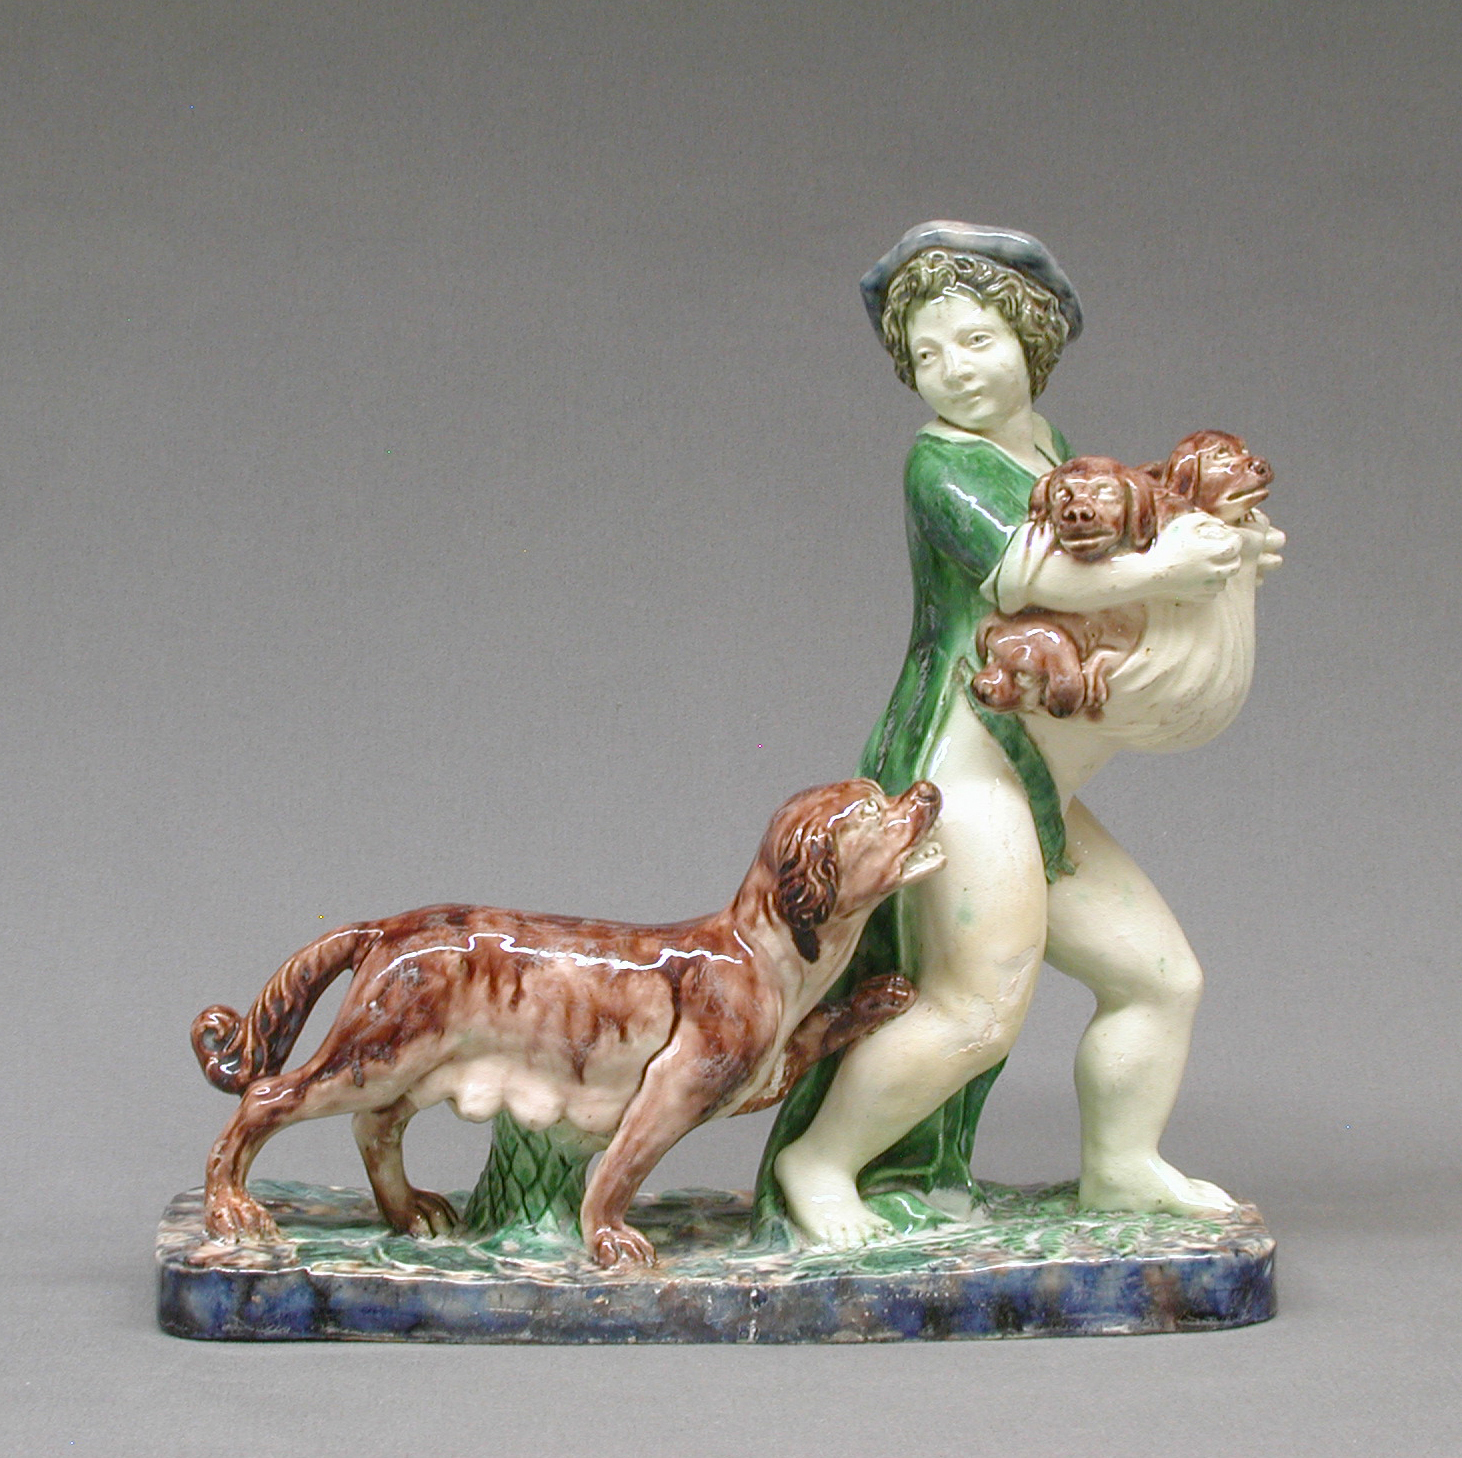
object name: group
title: Boy carrying pups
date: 1605-1610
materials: earthenware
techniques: glazing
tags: boys,dogs